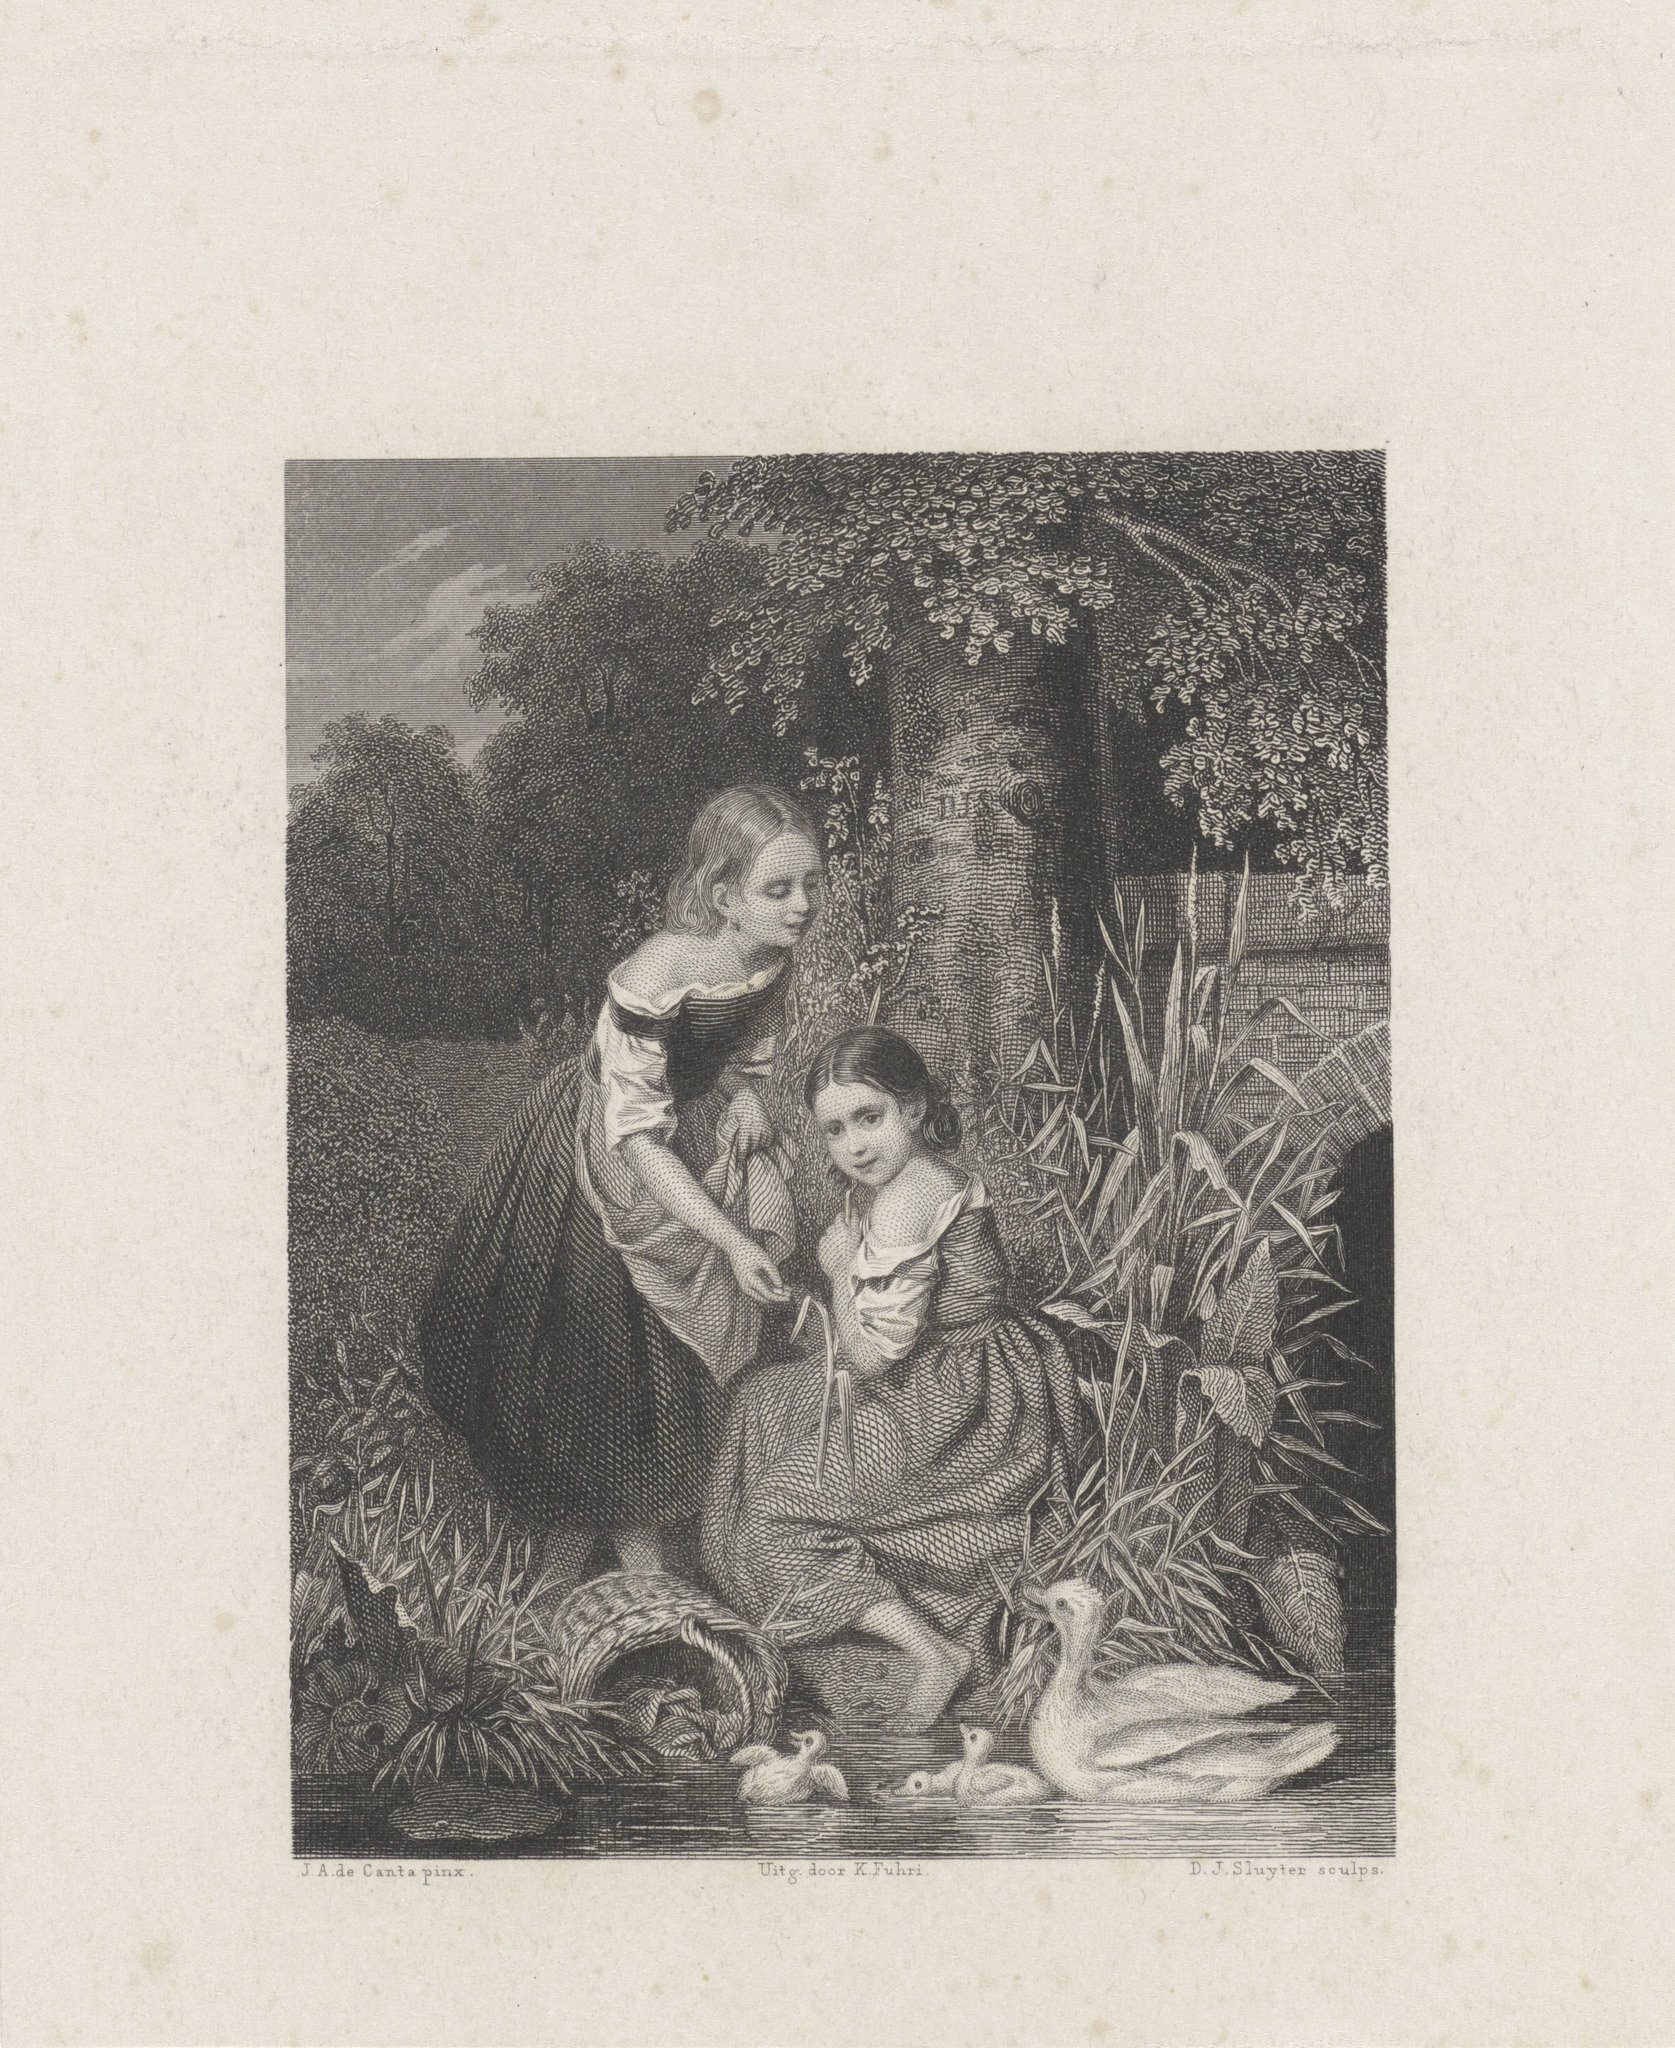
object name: book illustration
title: Kinderen aan de waterkant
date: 1848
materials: paper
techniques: engraving, etching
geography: the hague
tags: water-birds: duck (+ man and animal), girl (child between toddler and youth)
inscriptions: inscription: ‘Uit Aurora v. 1848’, collector's mark: Lugt 2228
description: Een meisje met een rietstengel in de hand zit aan de waterkant. Naast haar staat een tweede meisje, dat de eendjes in het water voert. Half in het water ligt een omgevallen mand. In de bast van de boom op de oever staan de initialen van de prentmaker gekerfd.